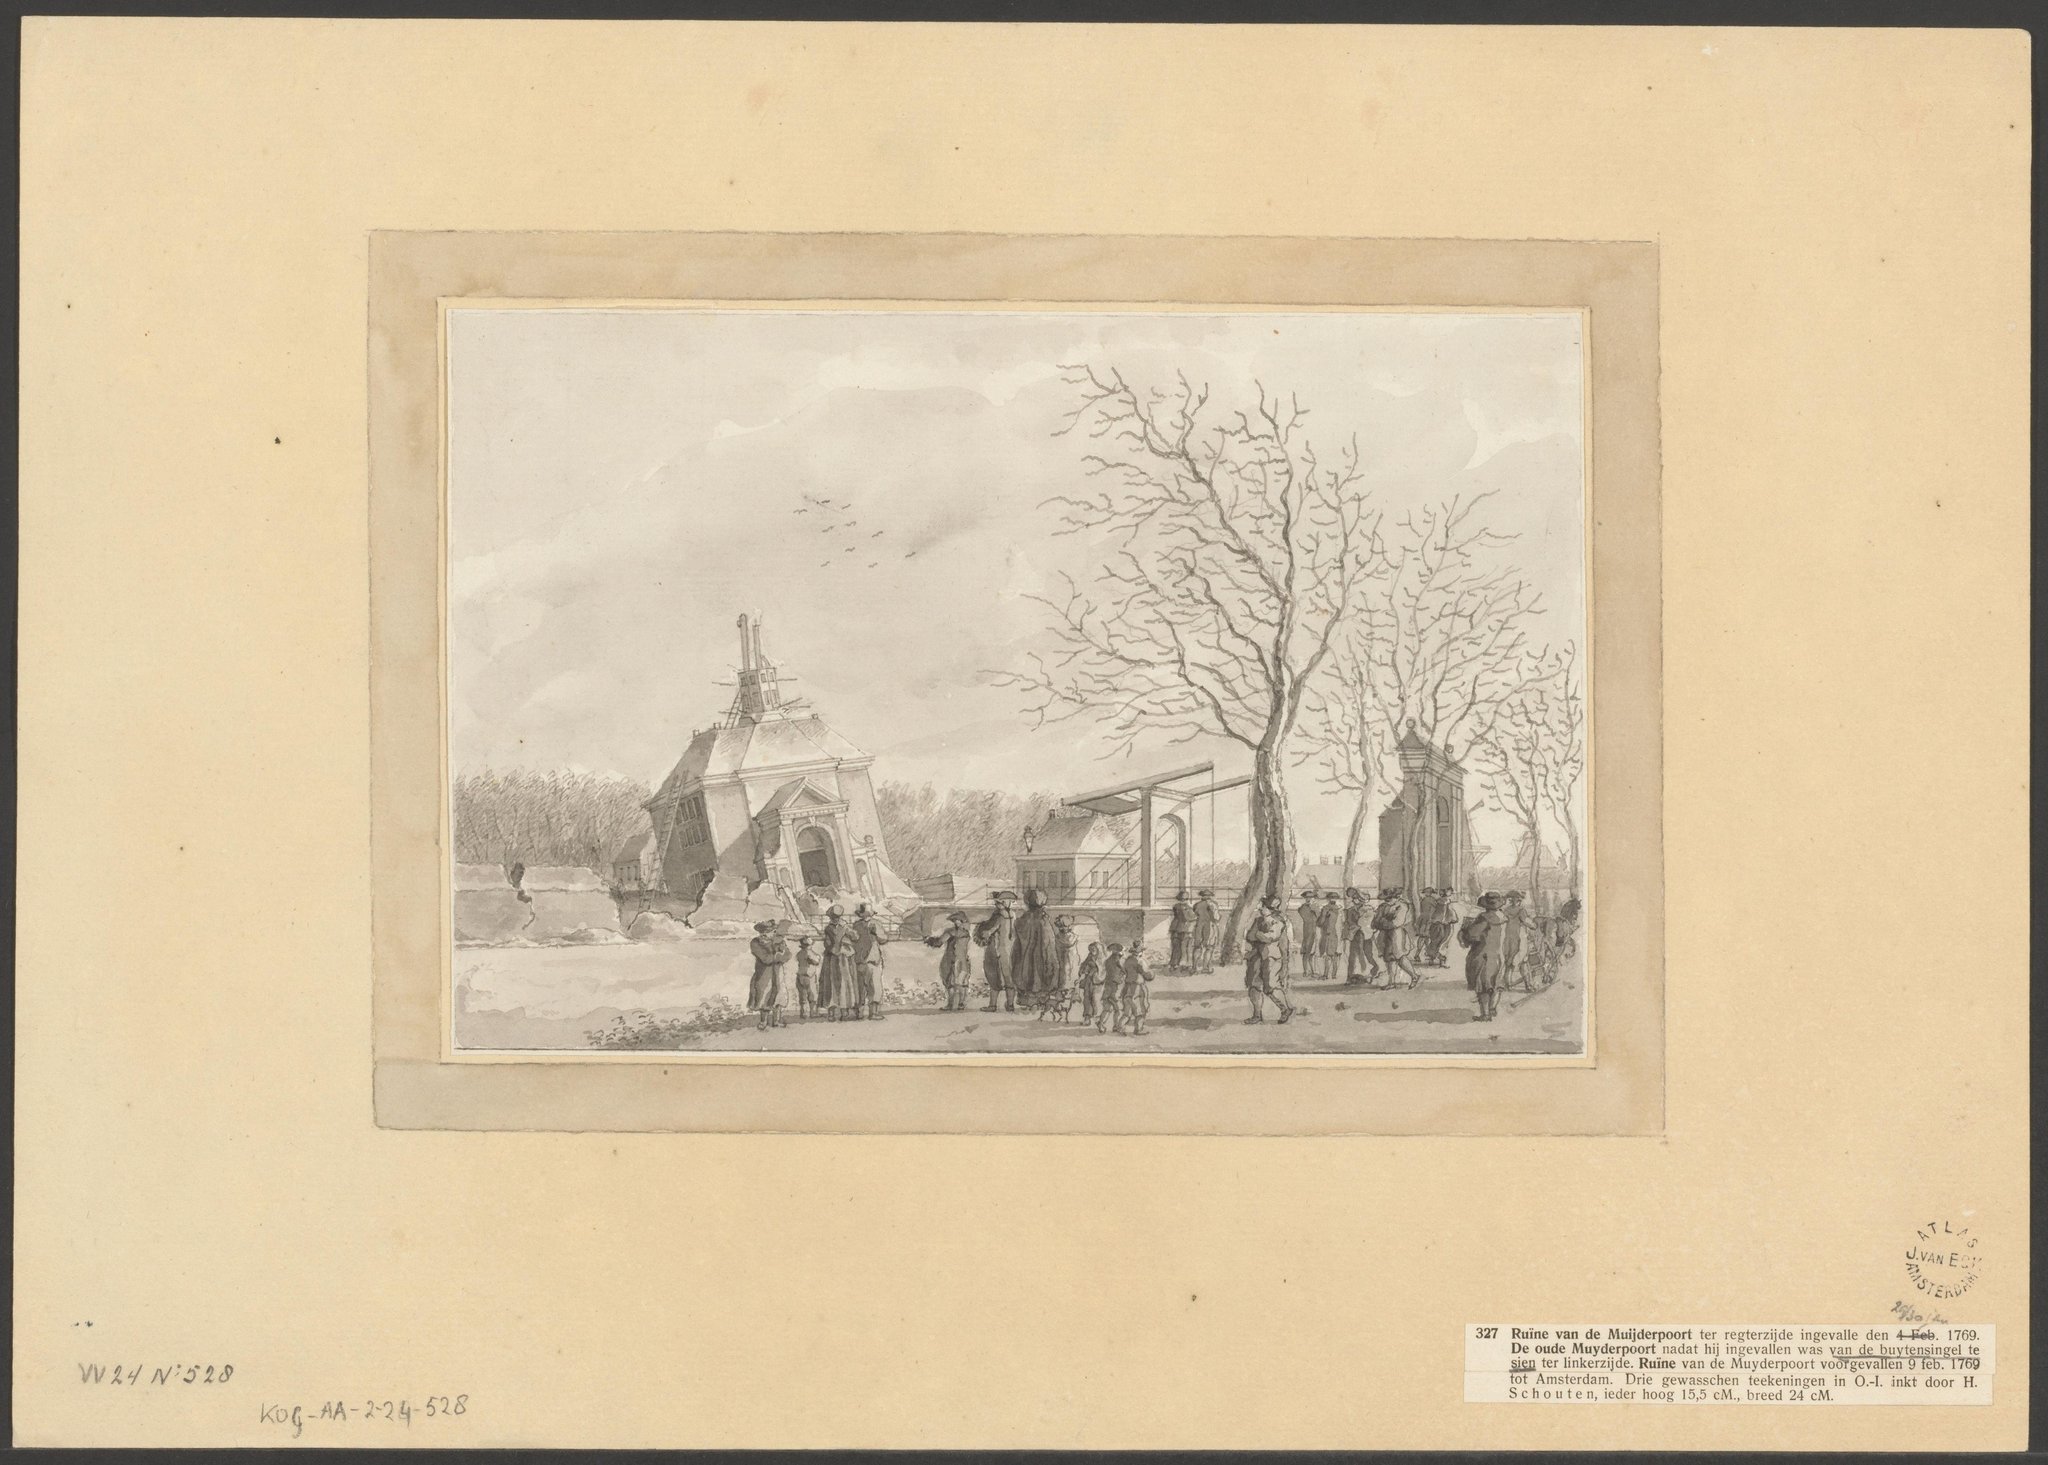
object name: drawing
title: Gezicht op de eerste Muiderpoort na de verzakking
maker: hermanus petrus schouten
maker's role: draughtsman, painter, print maker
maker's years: 1747-1822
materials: ink, paper, pencil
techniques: brush, pen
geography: amsterdam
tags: city-view in general; 'veduta', collapsing building, city-gate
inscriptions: inscription: ‘de oude muyderpoort na dat hij / ingevallen was van de buyte singel te sien / ten linkerzyde’, collector's mark: Lugt 800a, : ‘327 Ruïne van (...) breed 24 cM.’, collector's mark: Lugt 800a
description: Tekening binnen de Atlas Van Eck ingedeeld op wijknummer 24.